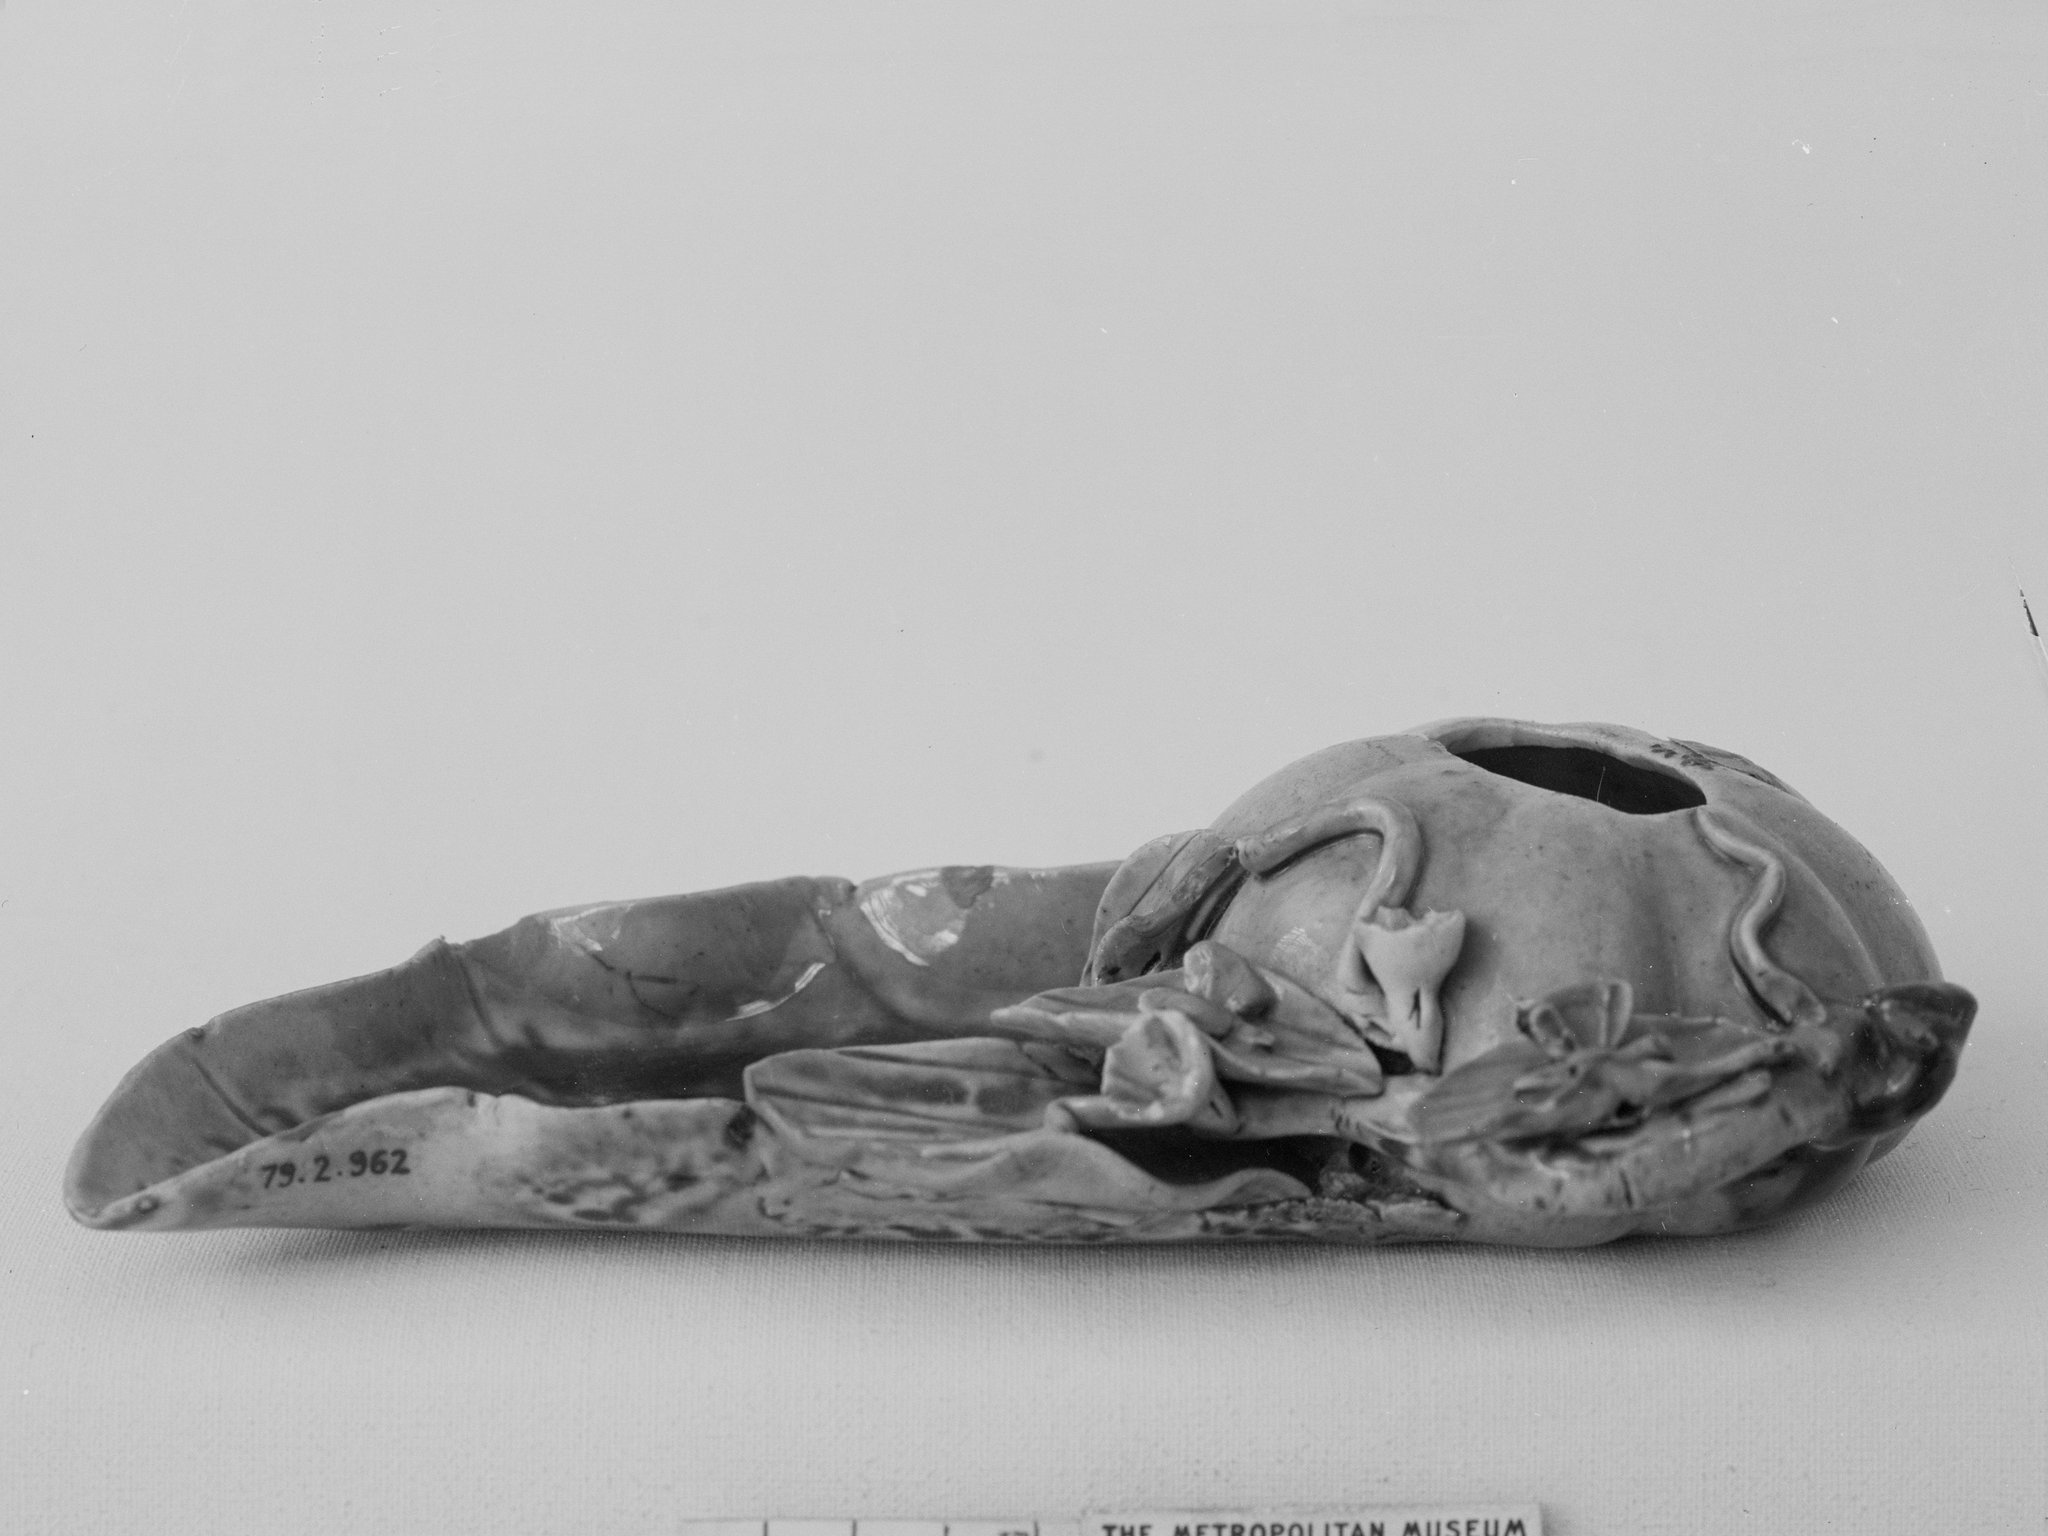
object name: water coupe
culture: chinese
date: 1662-1722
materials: biscuit, enamel, porcelain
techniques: painting